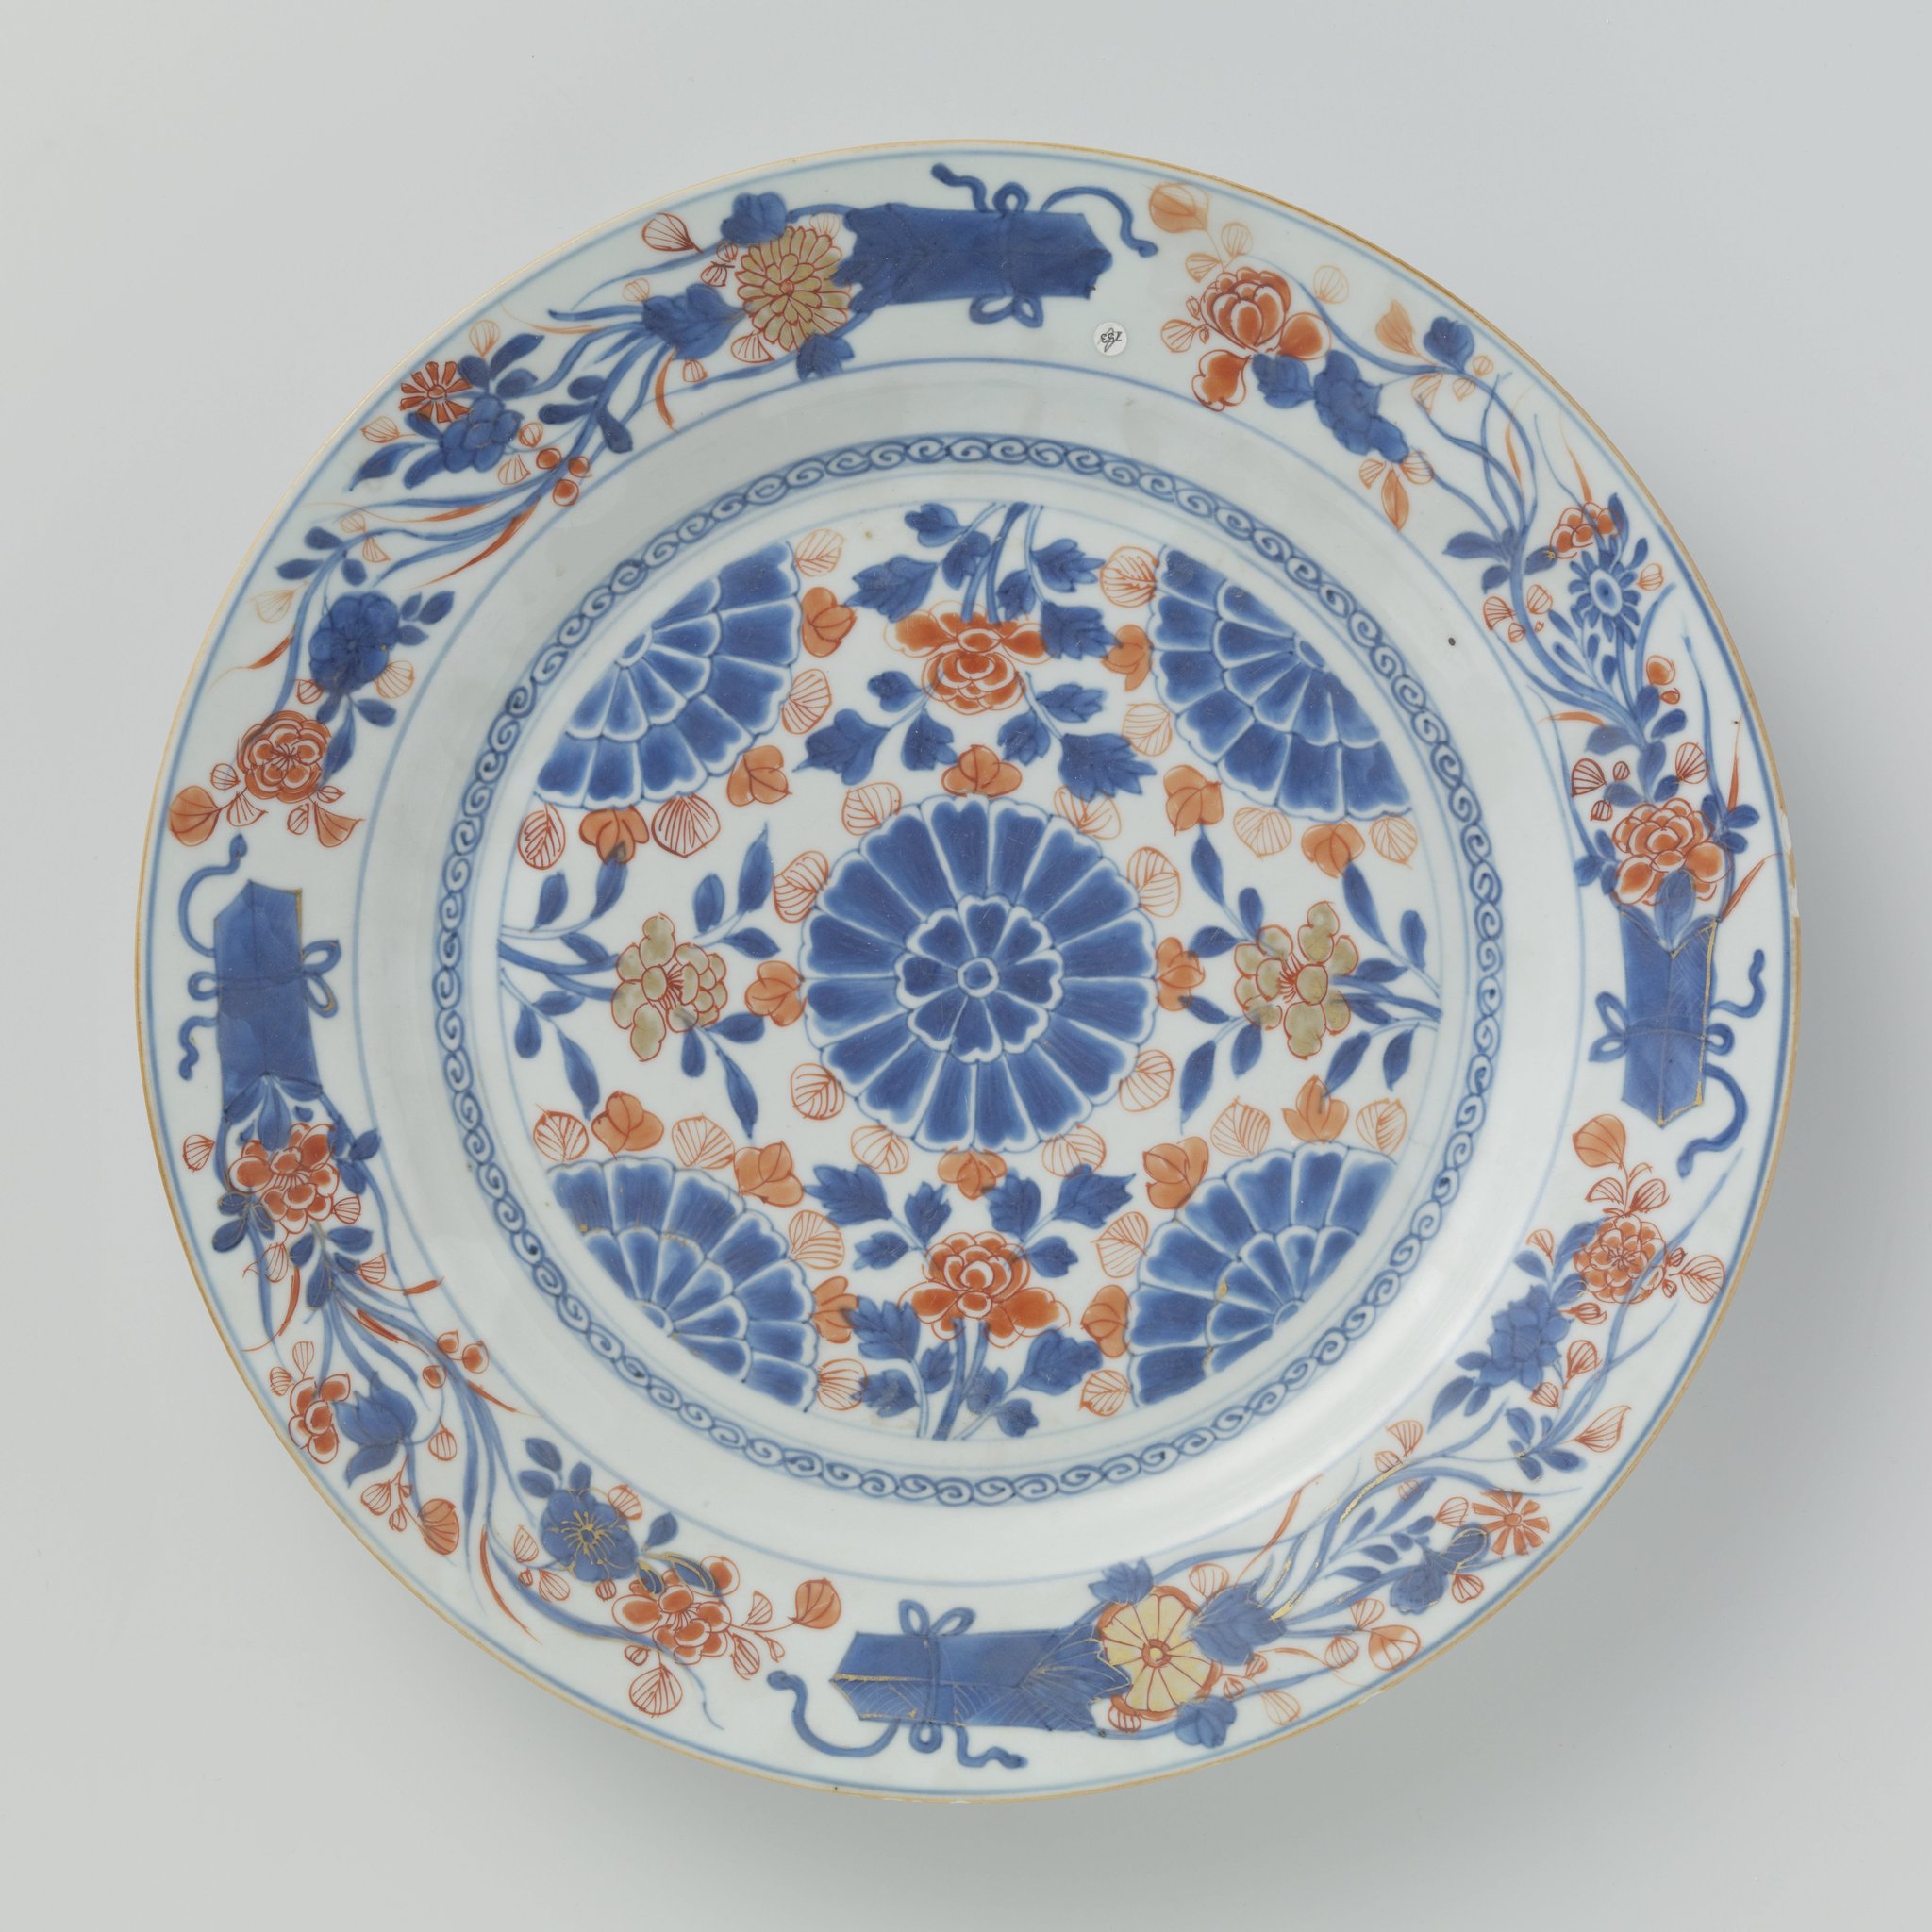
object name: platter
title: Dish with stylized flower heads, flower sprays and bouquets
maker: Anonymous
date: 1700-1724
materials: cobalt, glaze, gold, paint, porcelain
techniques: firing, gilding, turning, vitrification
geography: china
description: Bord, gedecoreerd in Chinees Imari-kleuren. bloemtakken, boeketten.